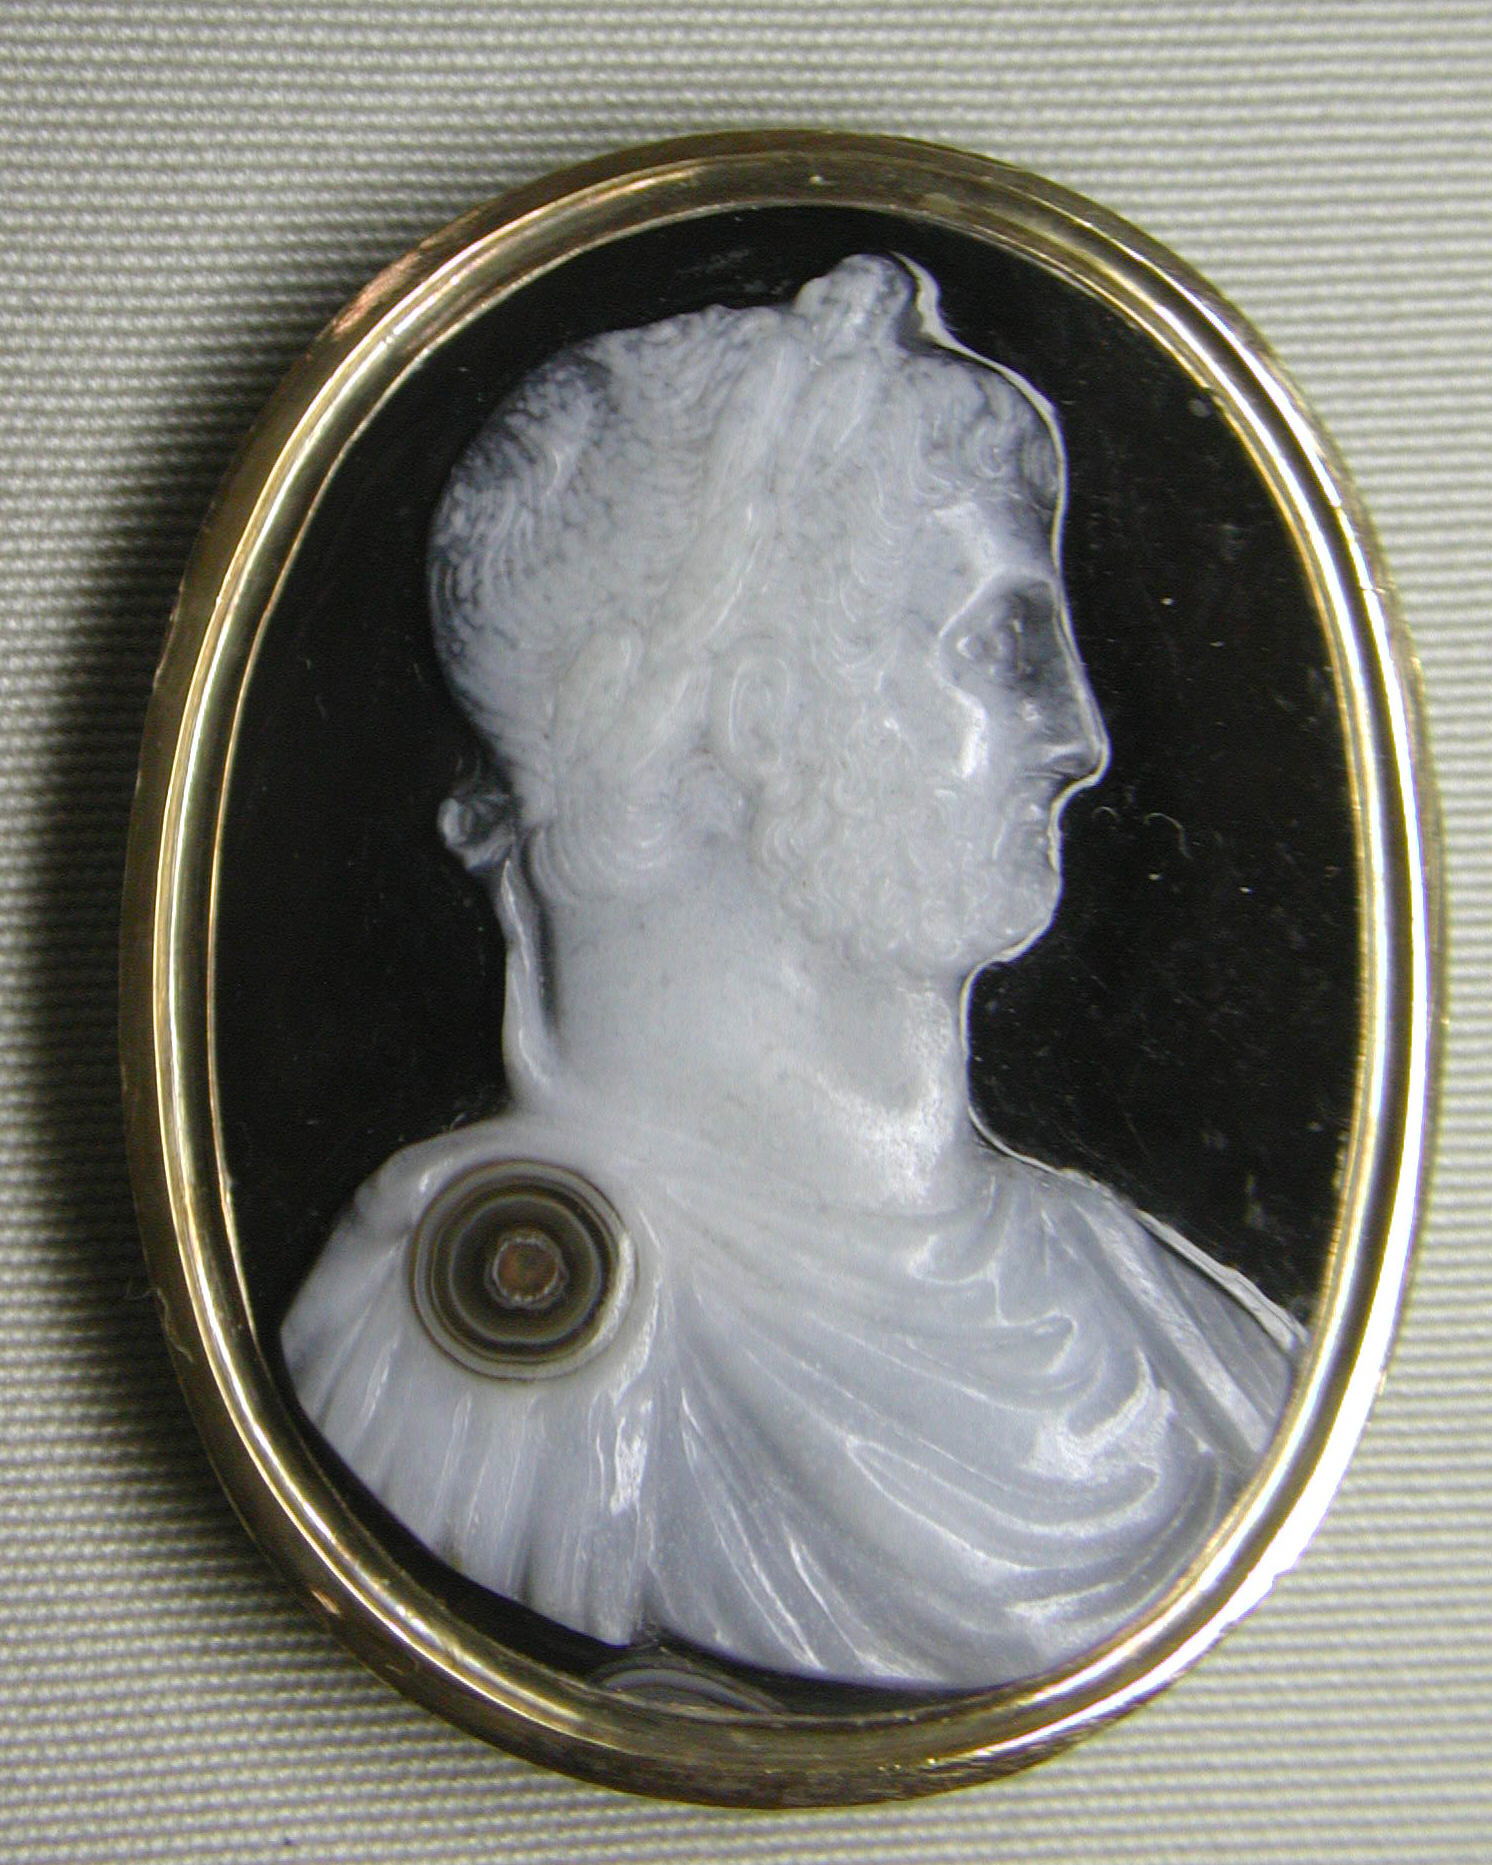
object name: cameo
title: Bust of the Emperor Hadrian (Publius Aelius Hadrianus, 76–138 A.D.)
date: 1501-1700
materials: gemstone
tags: men,profiles